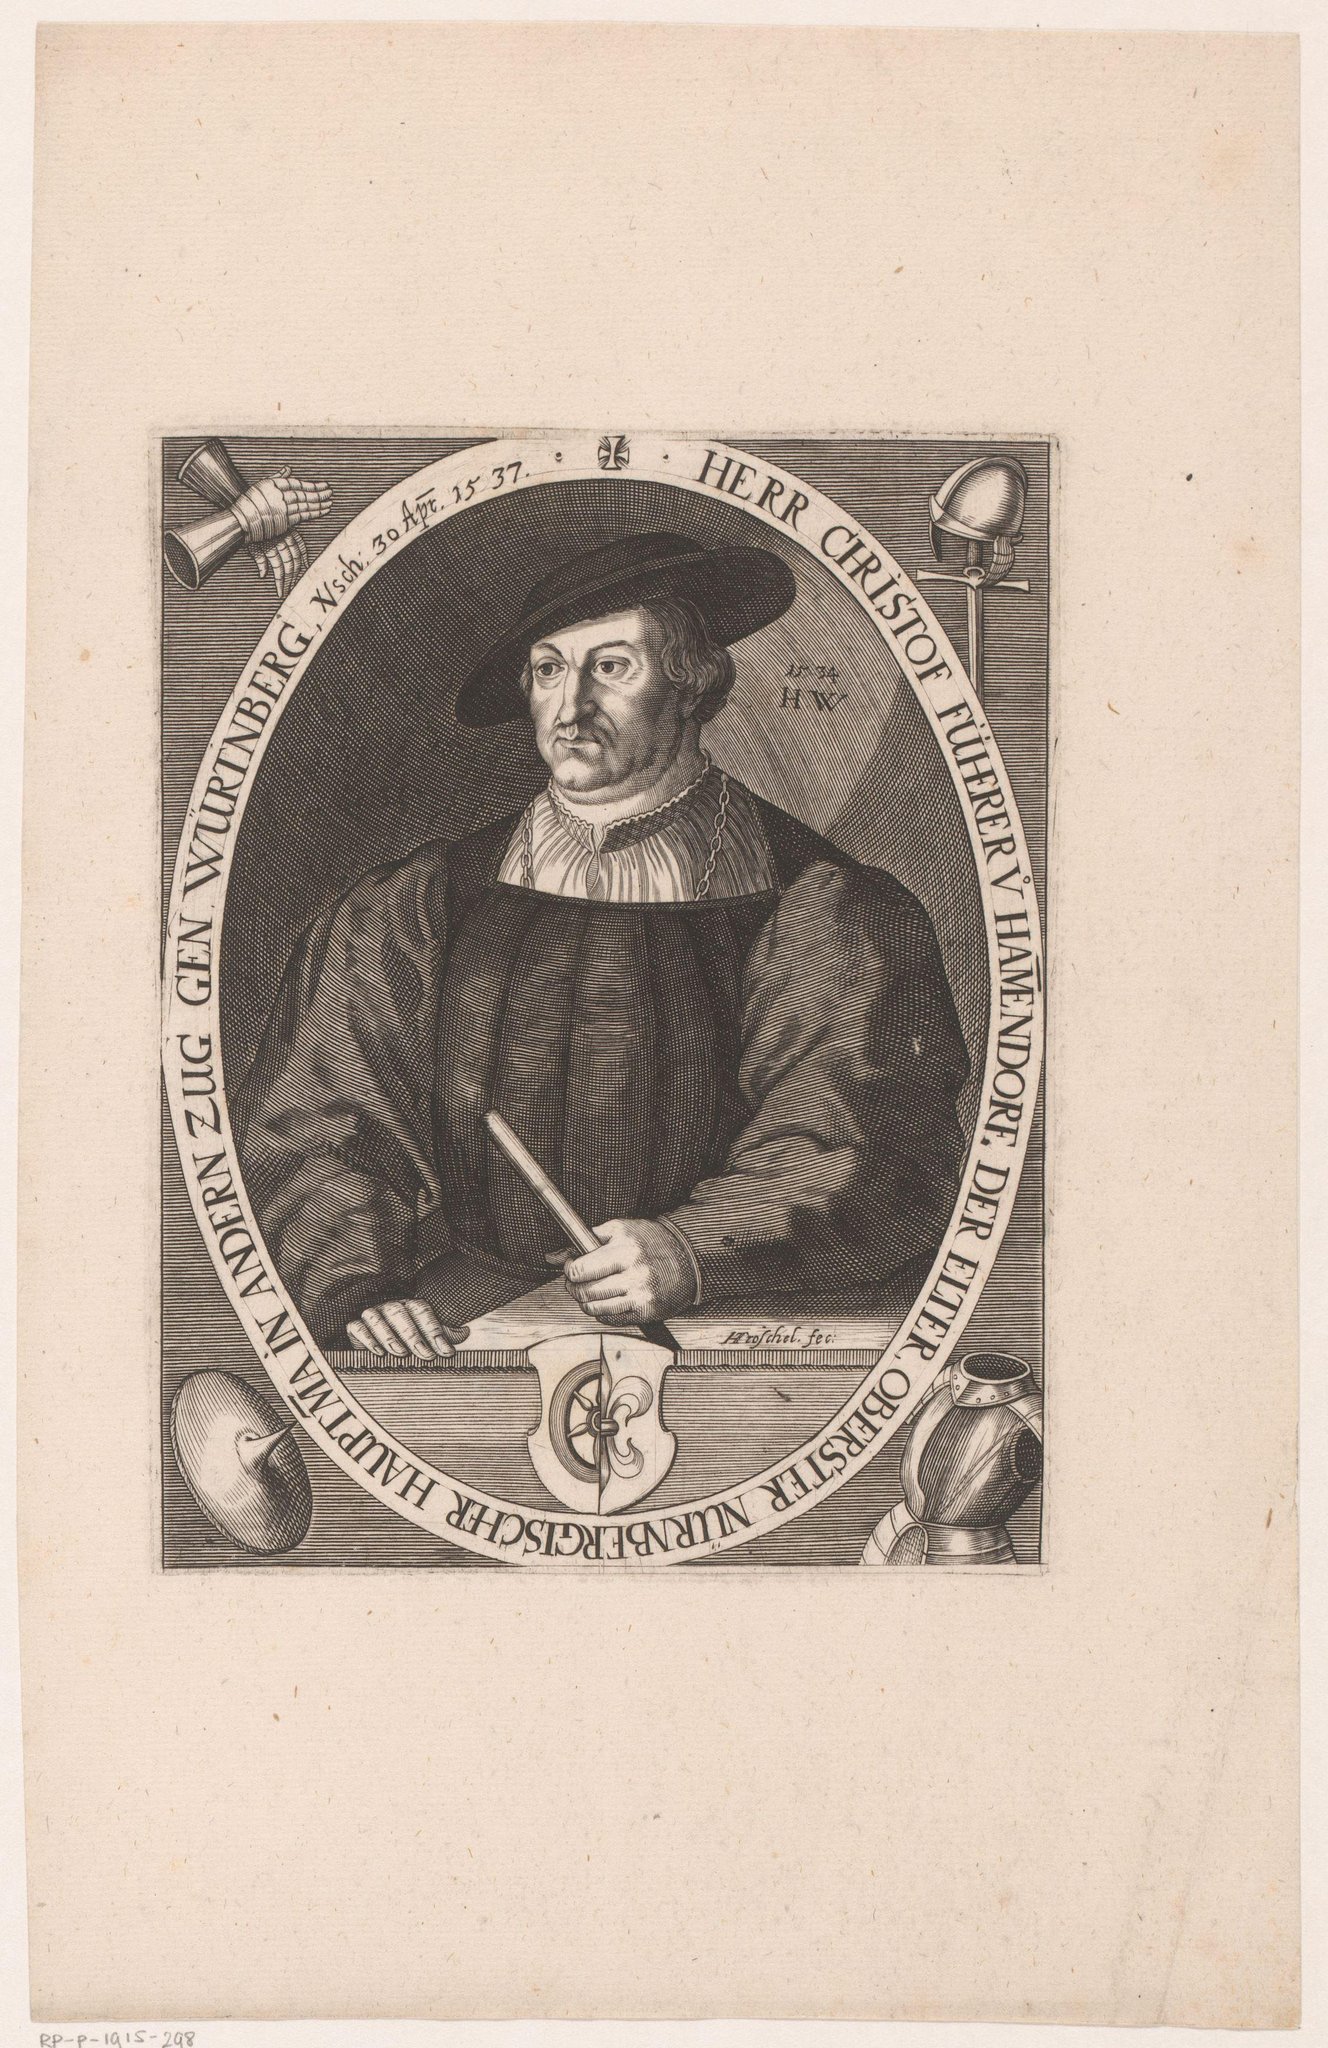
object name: print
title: Portret van Christoph I Fürer von Haimendorf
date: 1595-1628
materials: paper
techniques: engraving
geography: germany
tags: armour, historical persons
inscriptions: collector's mark: Lugt 2228